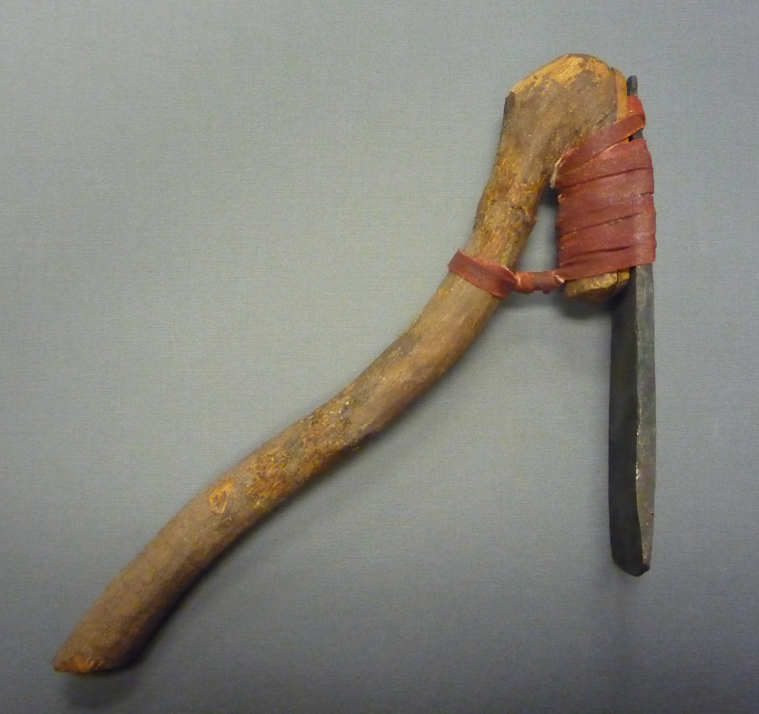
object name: adze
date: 1550-1295 BCE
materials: bronze, copper alloy, leather, wood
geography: egypt